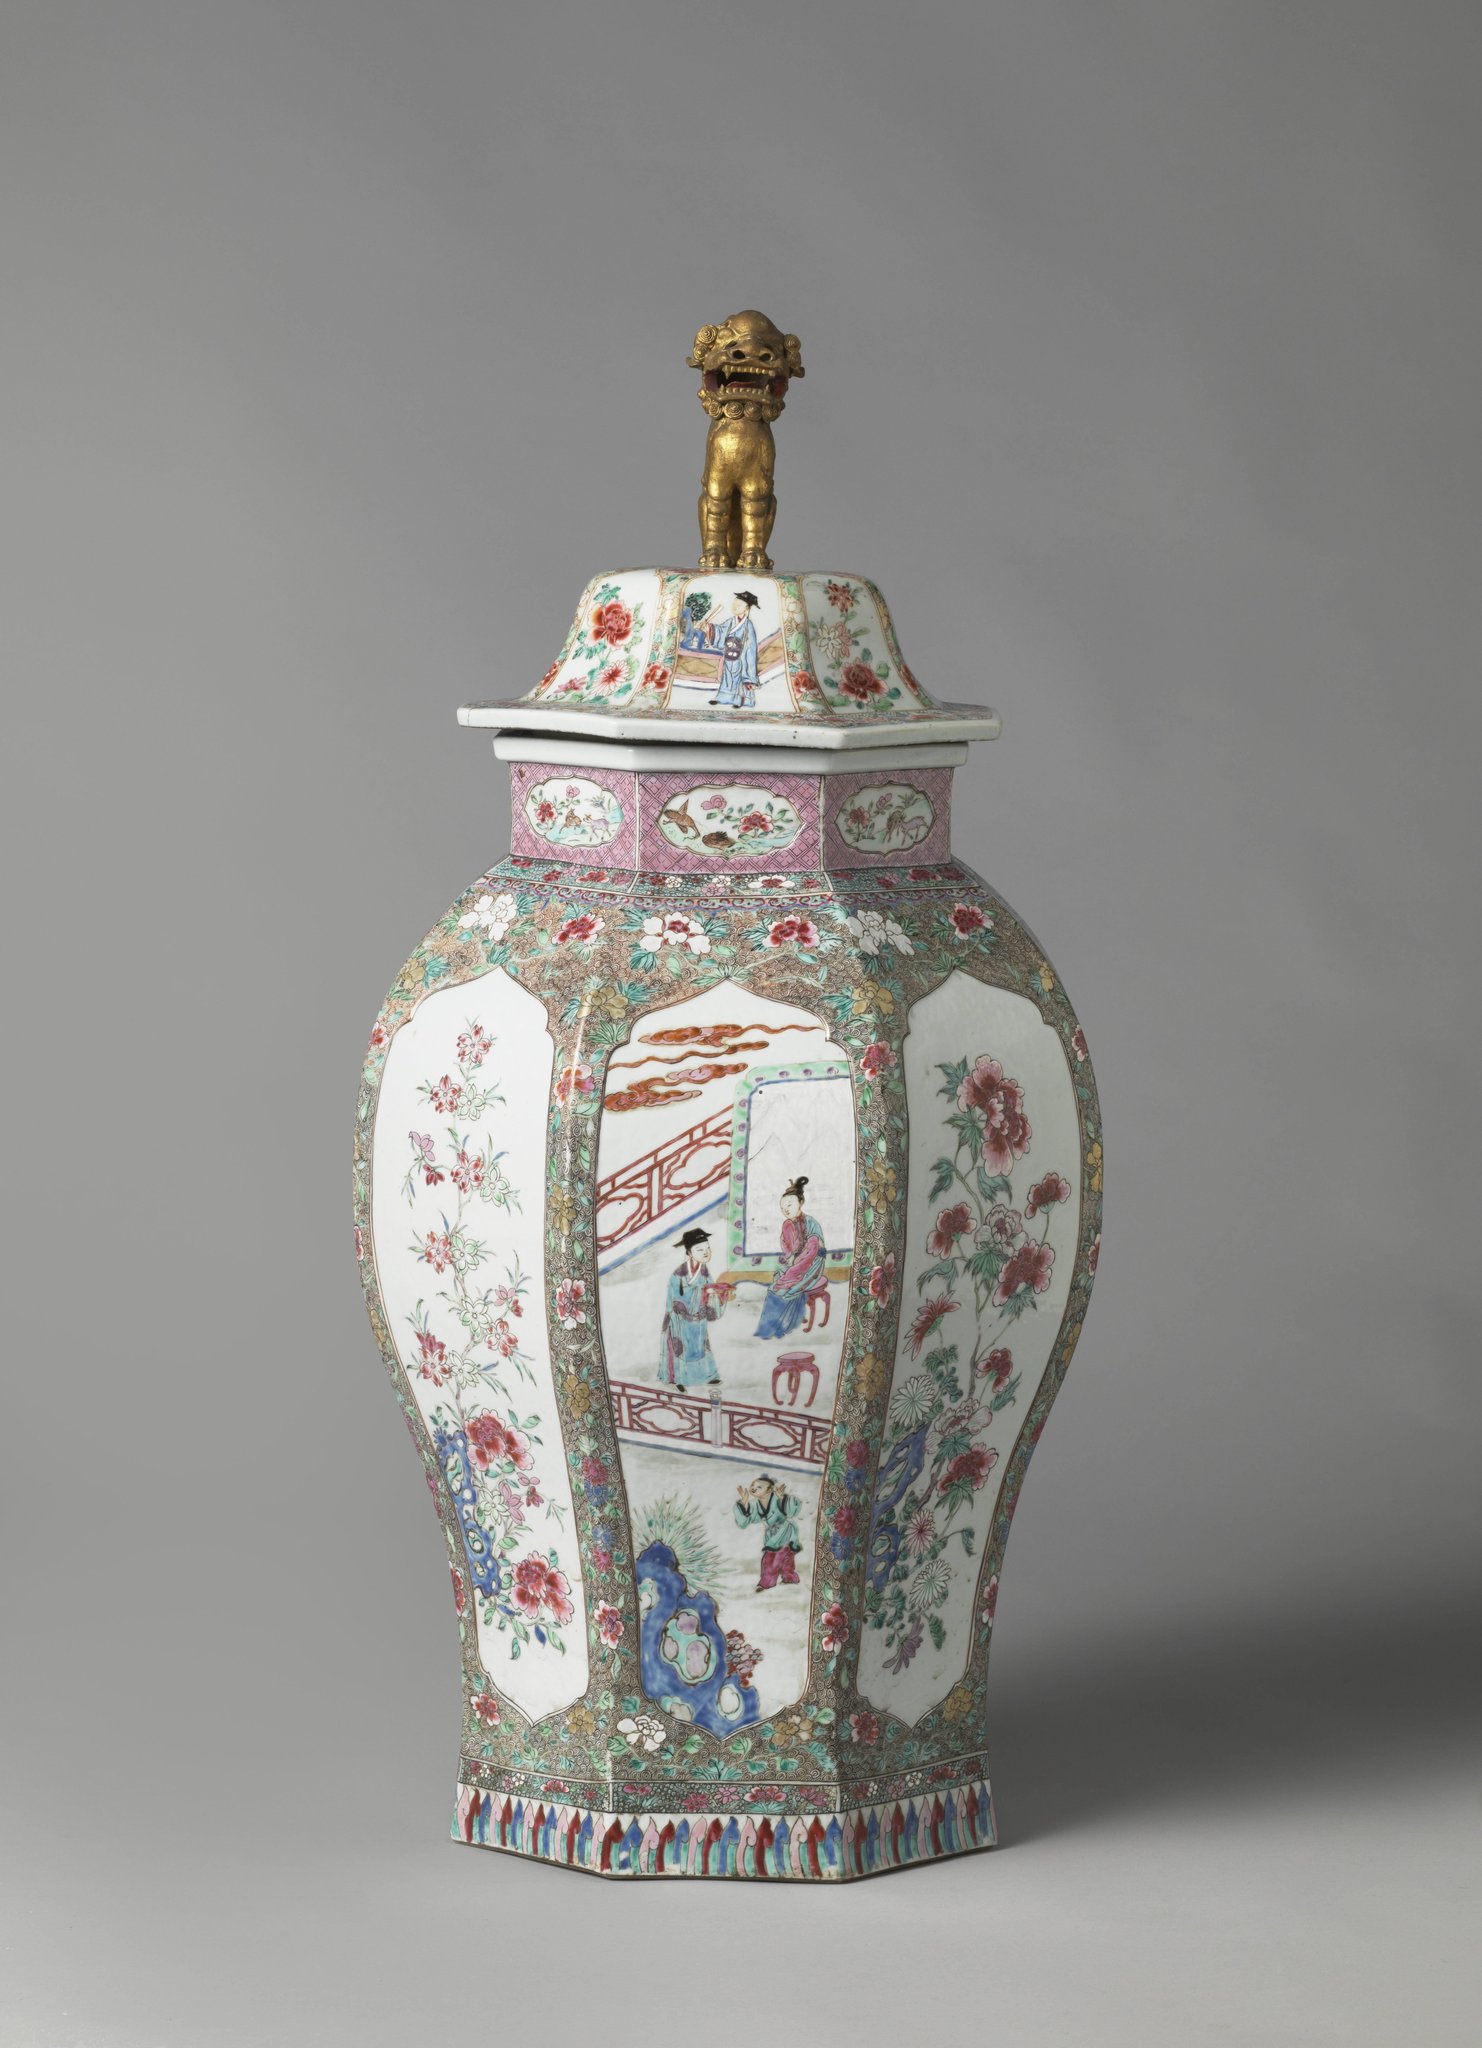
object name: covered jar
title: Garniture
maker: Anonymous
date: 1800-1899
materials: glaze, gold, paint, porcelain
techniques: firing, forming, gilding, turning, vitrification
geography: china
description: When the fashion for lavishly decorating interiors with porcelain arose around 1700, so-called garnitures were designed in sets of five or sometimes seven lidded jars and trumpet vases. They were used as display pieces on mantels or cabinets, but this later, large set served as decoration in a fireplace when it was not in use during the summer.